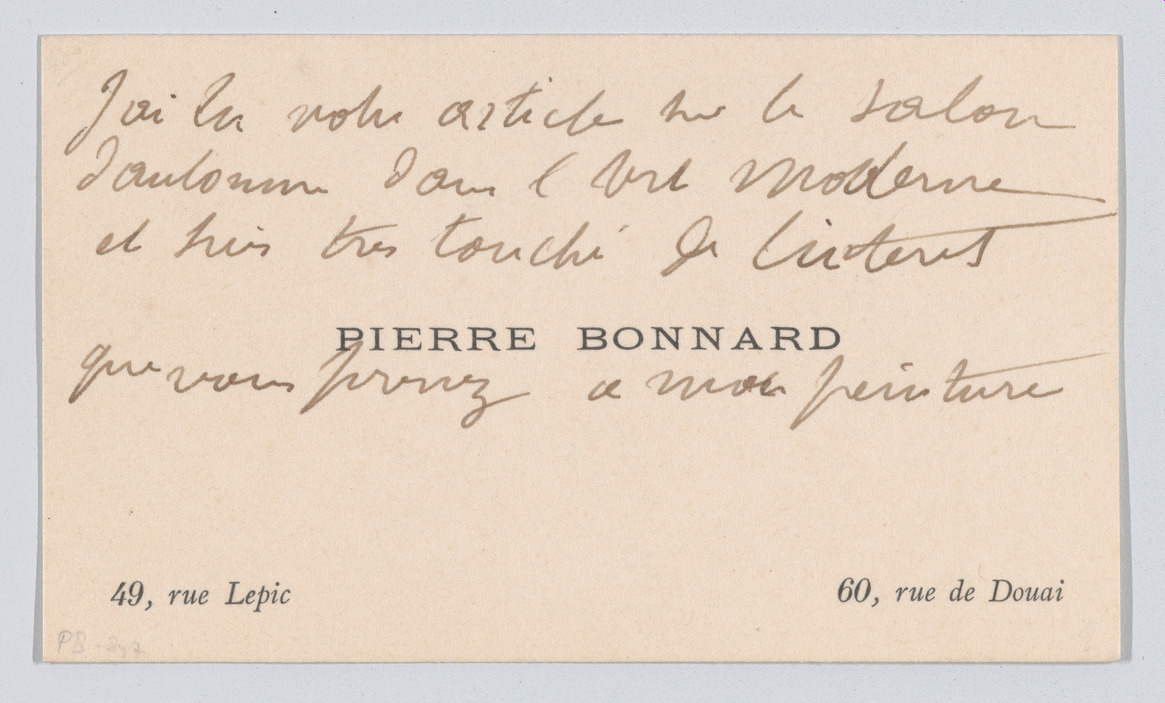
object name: print, calling card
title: Pierre Bonnard, calling card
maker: Anonymous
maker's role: artist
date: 1889-1947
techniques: engraving